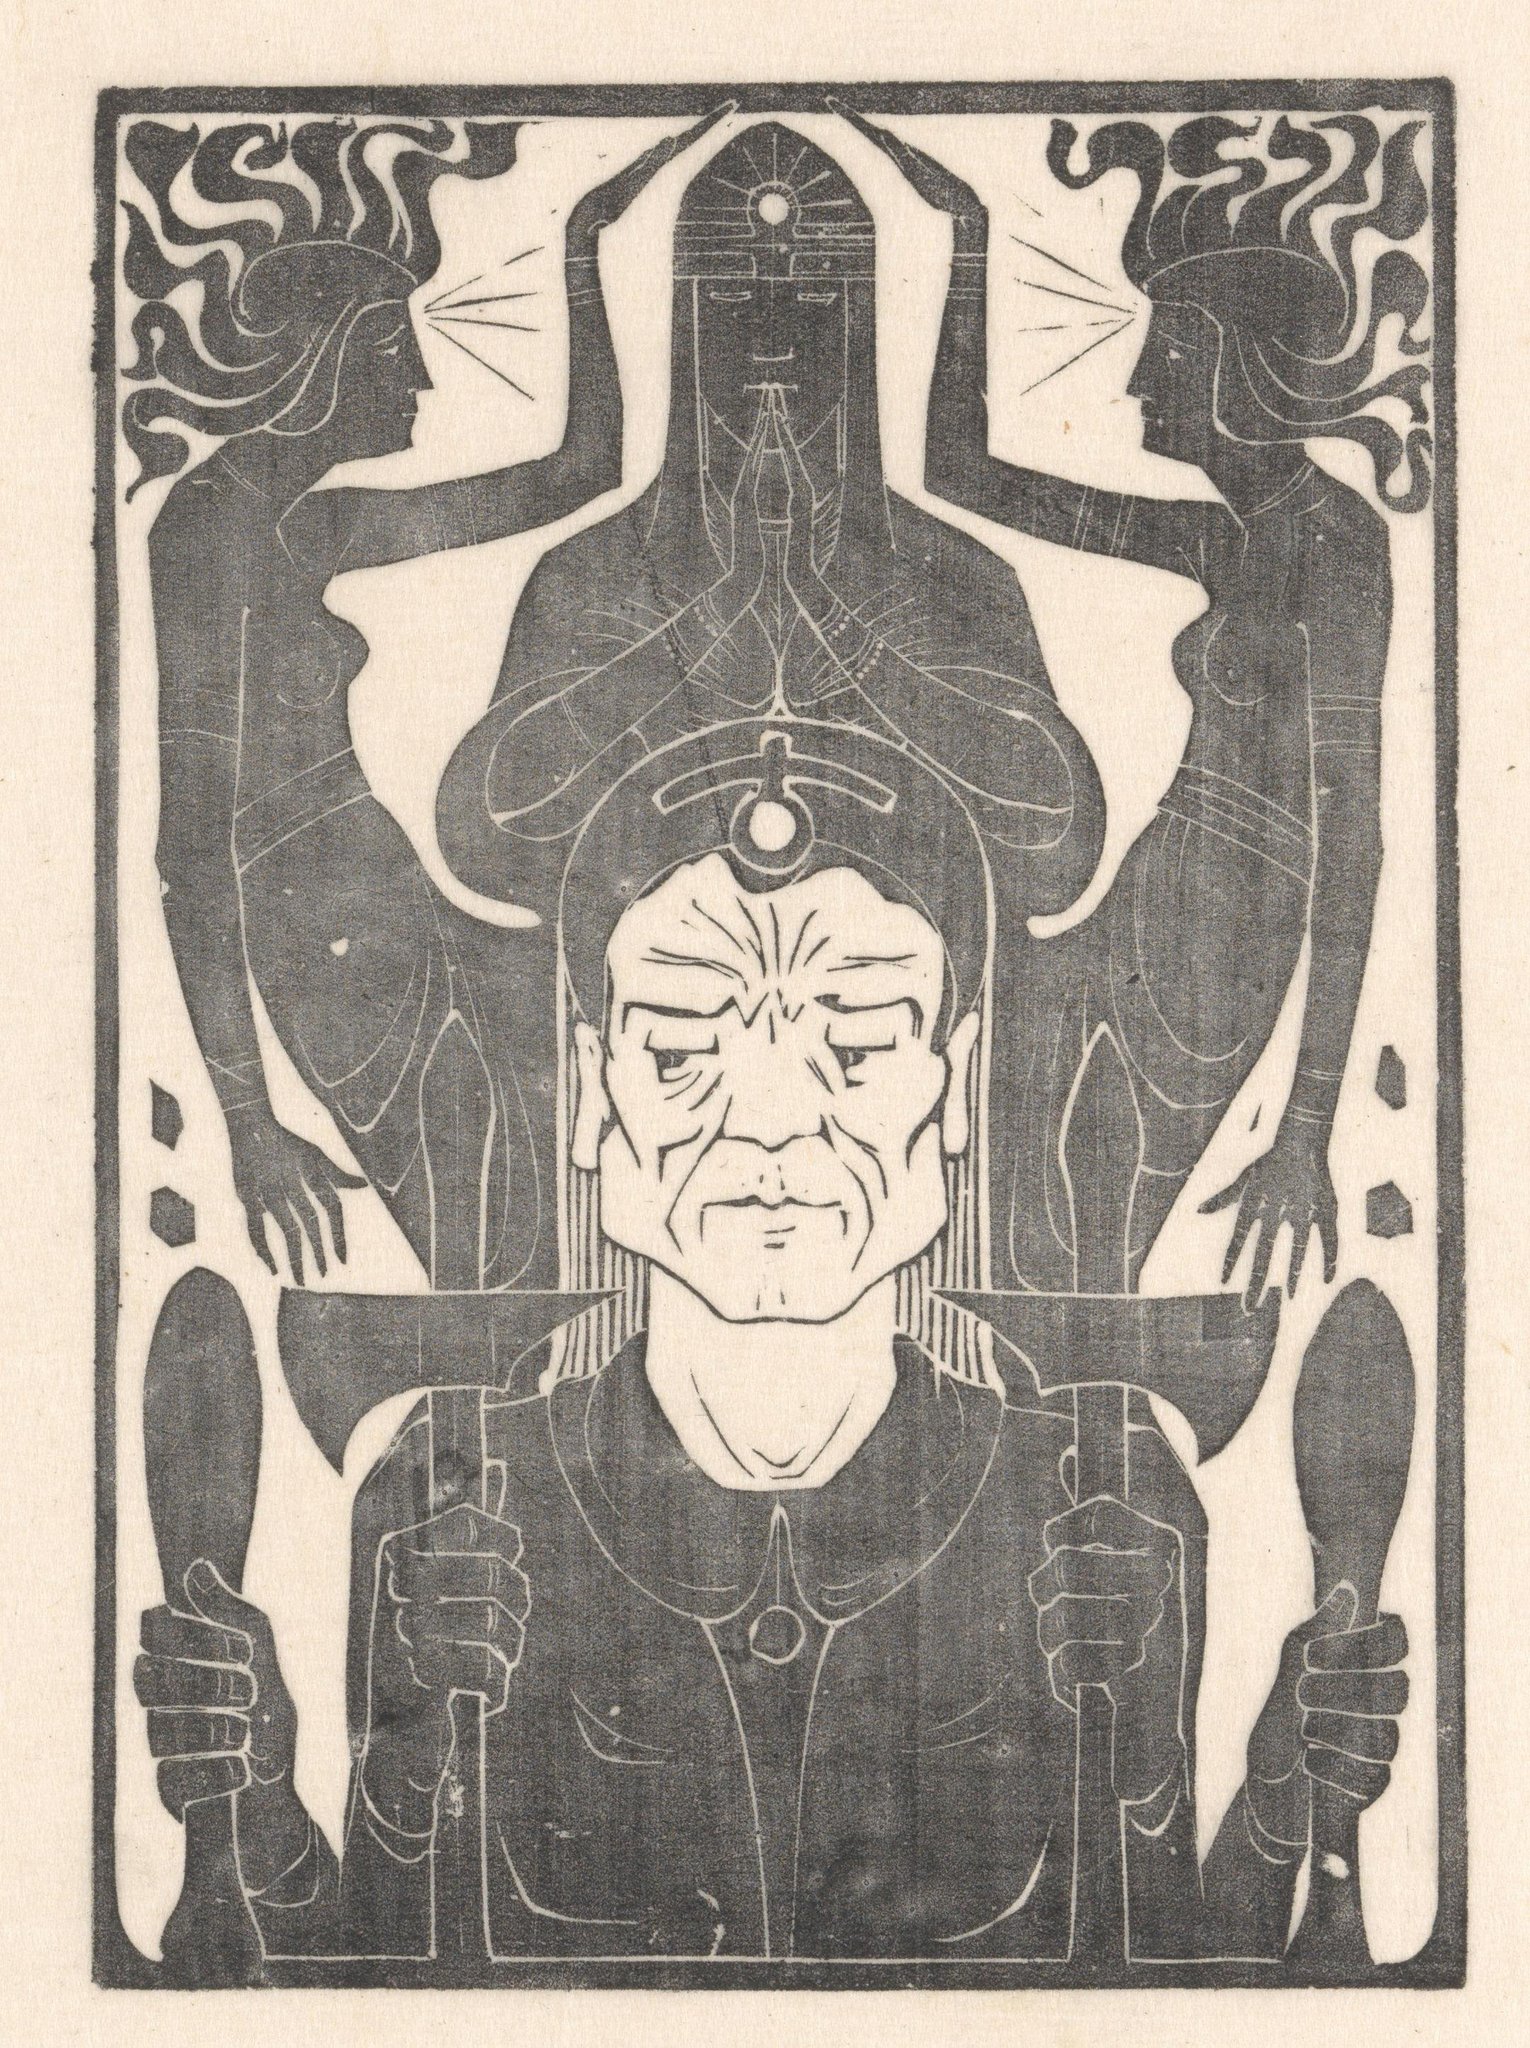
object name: print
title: Drie figuren bij een bewapende man met vier armen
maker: karel petrus cornelis de bazel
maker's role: draughtsman, print maker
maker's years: 1869-1923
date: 1894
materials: paper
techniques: woodcut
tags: hacking and thrusting weapons, postures and gestures of the palm of the hand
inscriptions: collector's mark: Lugt 2228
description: Boven een man met hoofddeksel die zijn handpalmen op schouderhoogte tegen elkaar houdt. Links en rechts van hem een halfnaakte vrouw. Beide vrouwen houden een handpalm boven het hoofd van de man. Onder een man met vier amen die in elke hand een wapen vasthoudt.